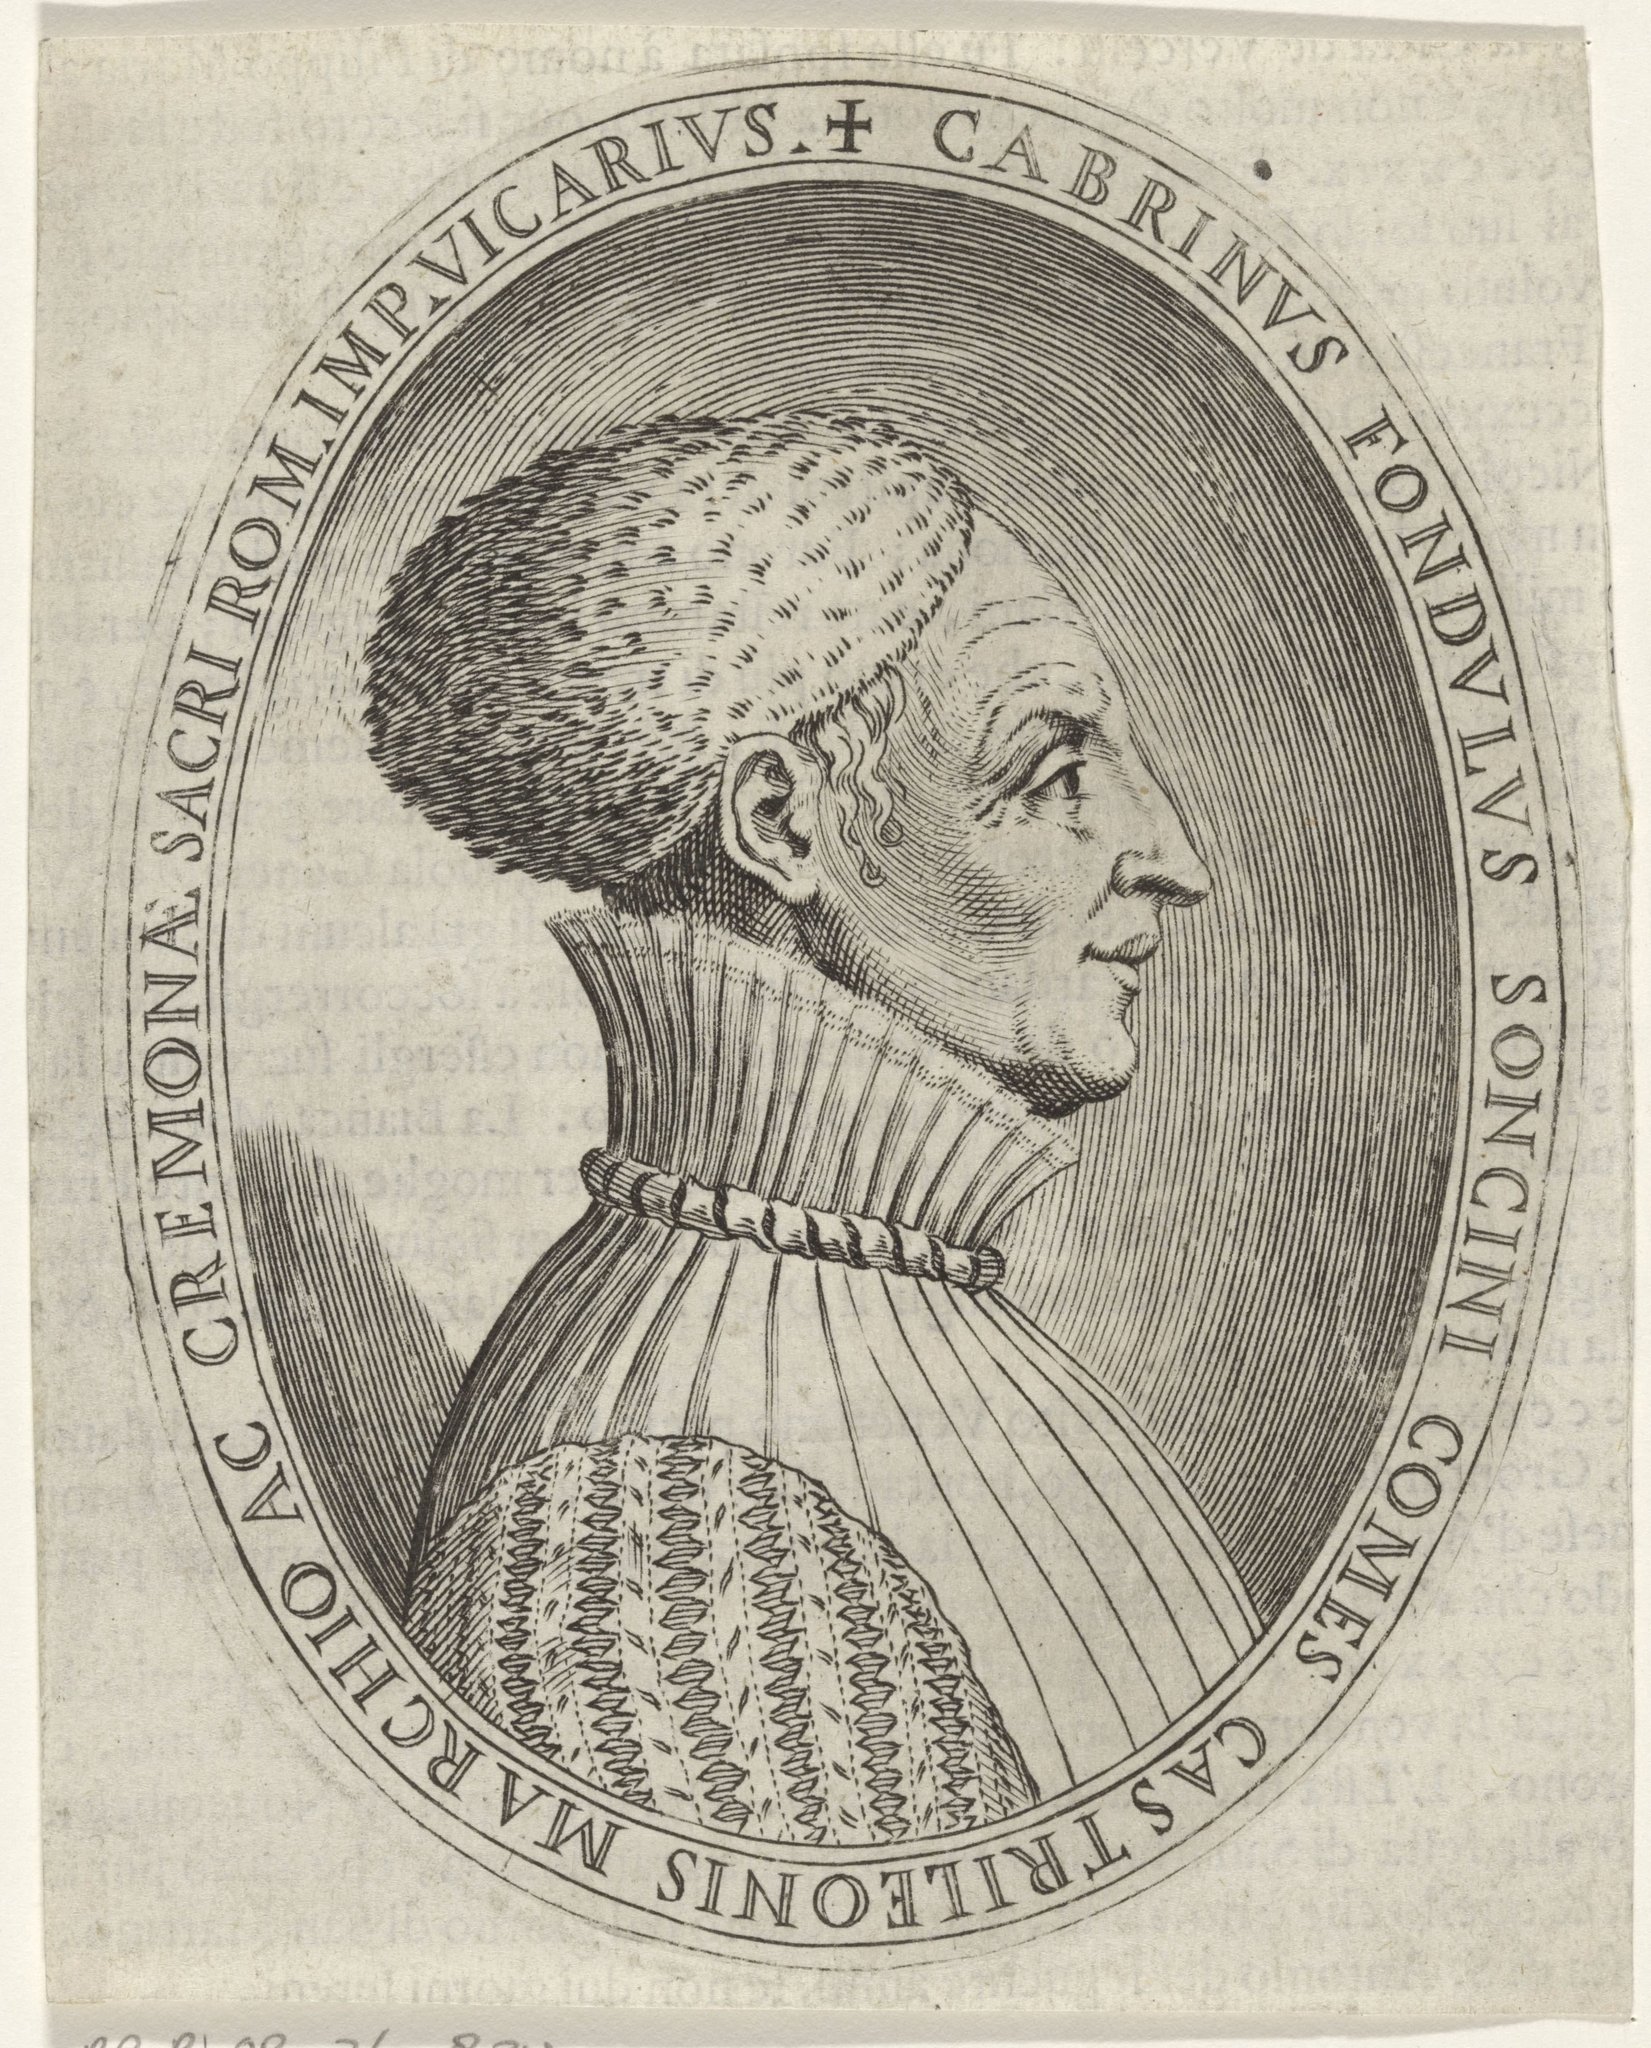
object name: print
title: Portret van Cabrino Fondulo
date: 1585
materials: paper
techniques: engraving, letterpress printing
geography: spain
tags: historical persons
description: Prent uit Antonio Campo, Cremona fedelissima citta, et nobilissima colonia de Romani rappresentata in disegno col suo contado; et illustrata d'una breve historia, Milaan: Filippo Ghisolfi 1642, vol. 3, p. 84.